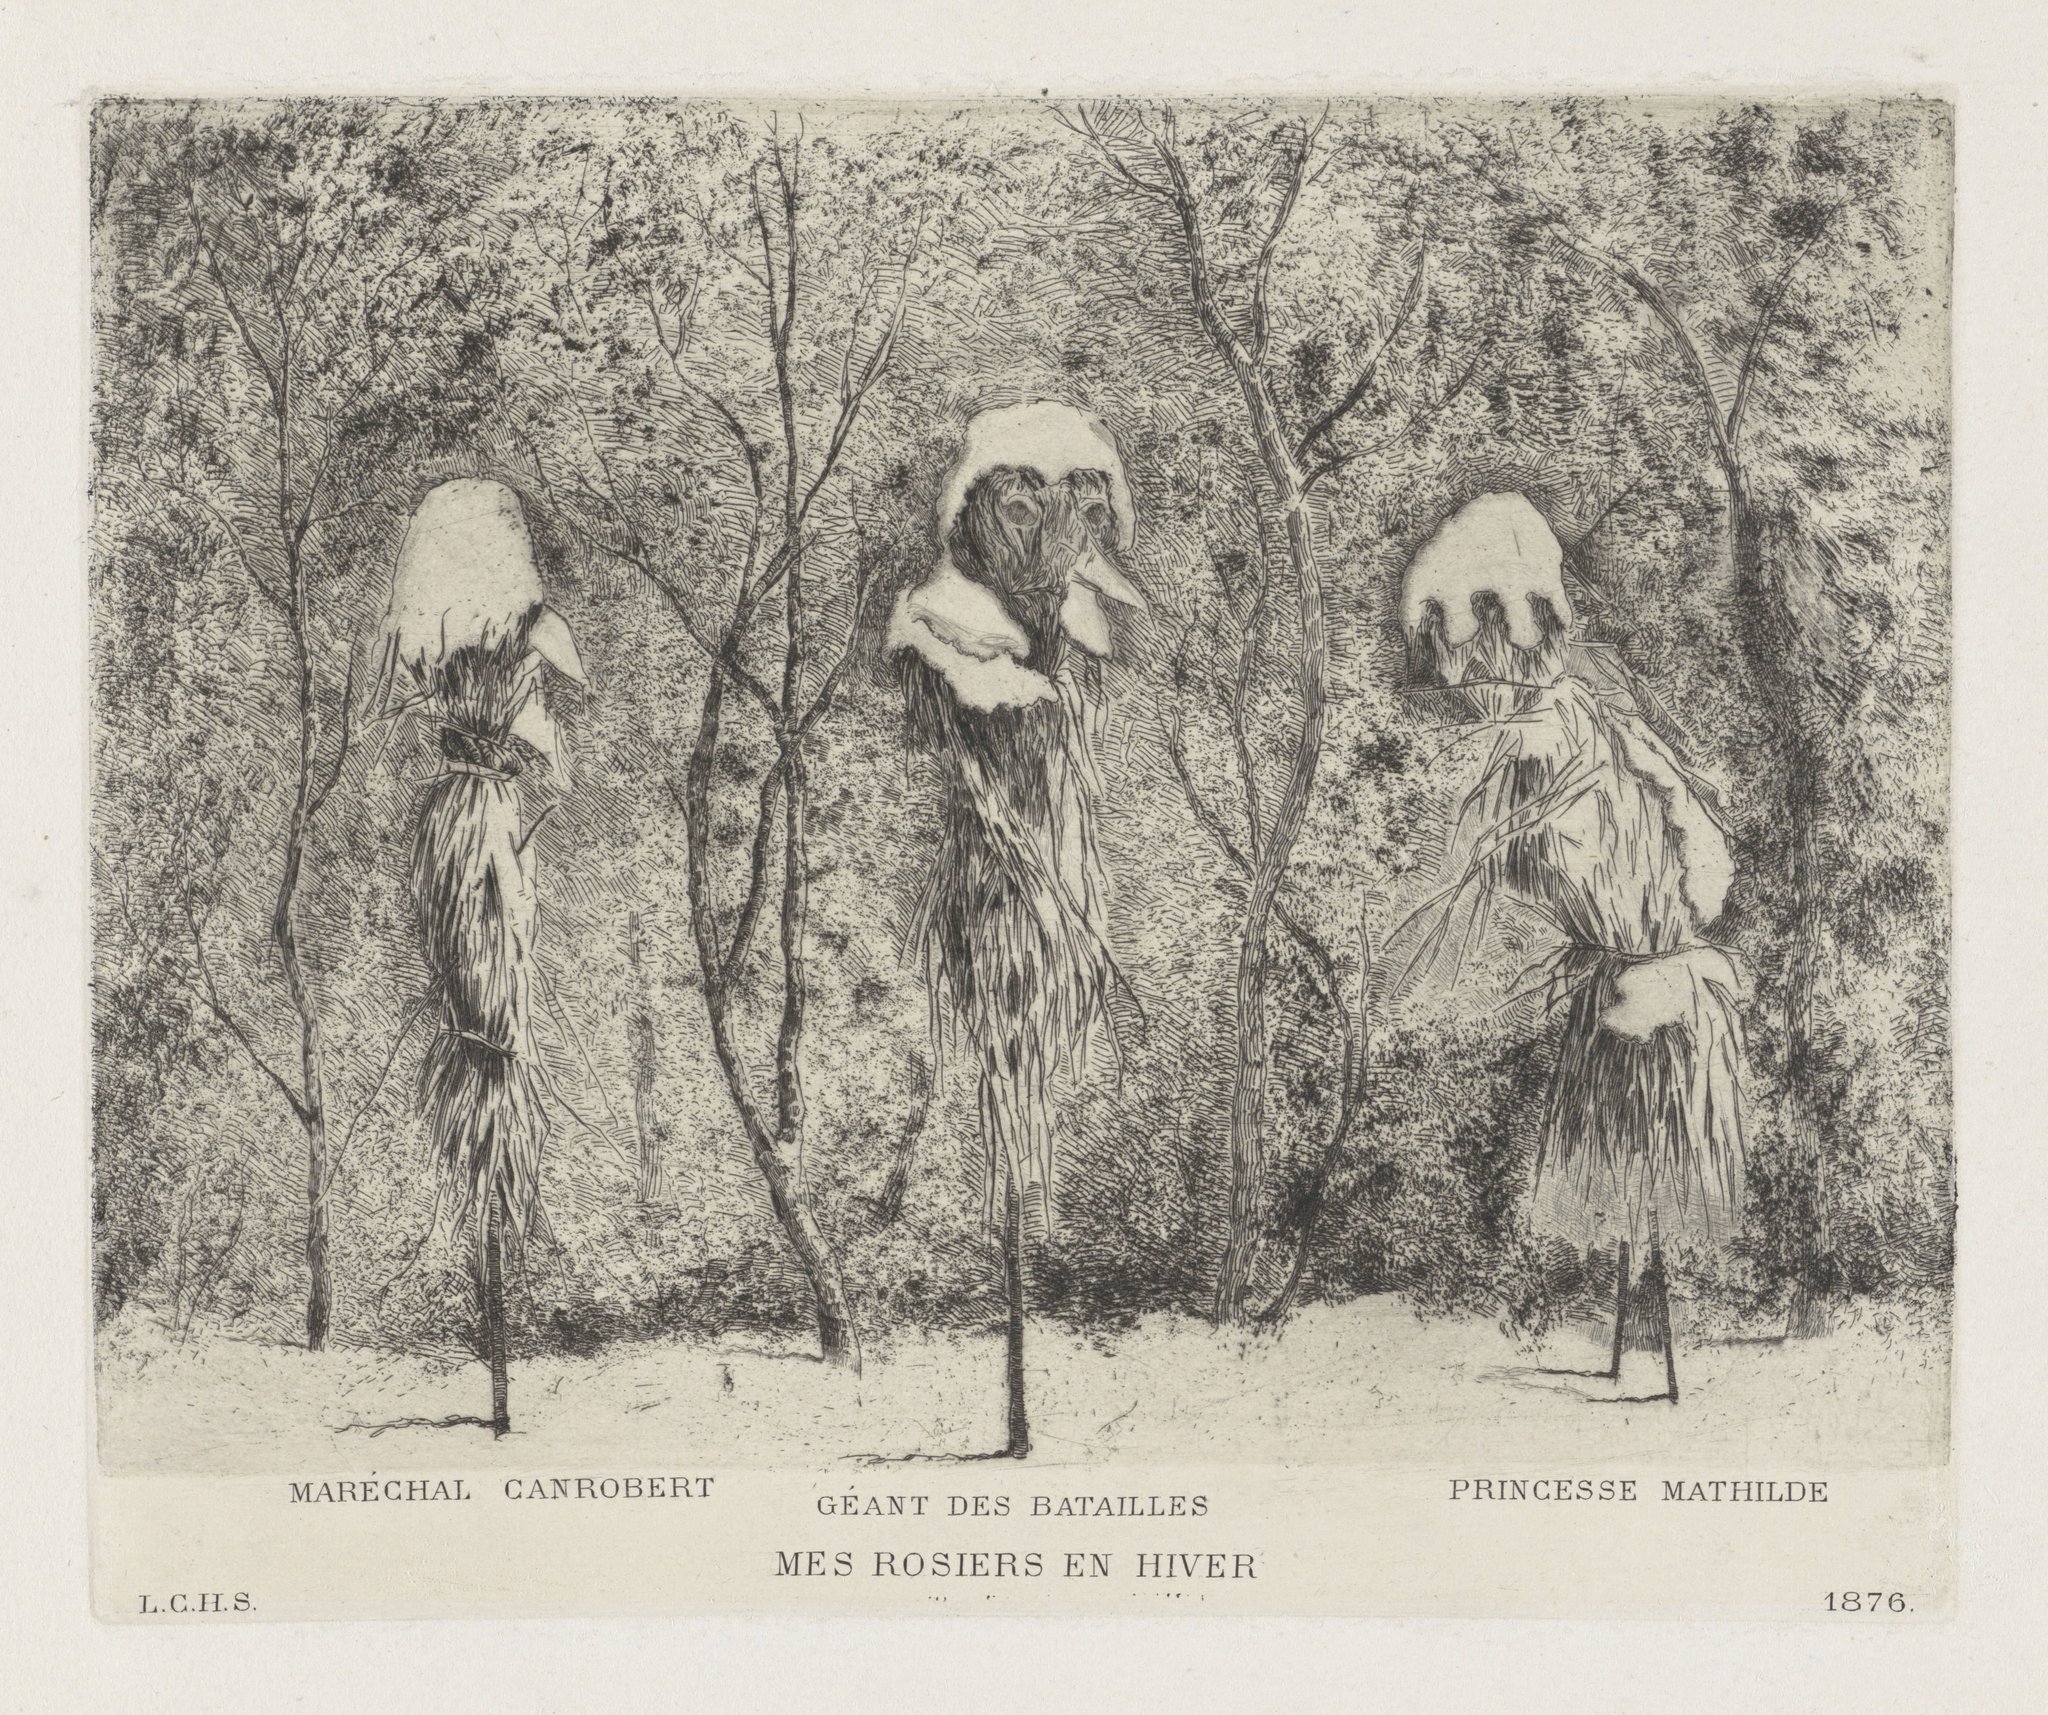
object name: print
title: Fantasie-compositie over de Frans-Duitse oorlog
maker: louis charles hora siccama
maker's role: draughtsman, print maker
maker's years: 1807-1880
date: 1876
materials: paper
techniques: drypoint, etching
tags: paris, mathilde laetitia wilhelmine bonaparte, flowers: rose, protection against damage and loss ~ agriculture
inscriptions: collector's mark: Lugt 2228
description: Drie tegen de vrieskou met stro ingepakte stamrozen, bedekt met sneeuw. De onderschriften identificeren de rozenstruiken met figuren uit de Frans-Duitse oorlog: François Certain Canrobert en Mathilde Bonaparte.